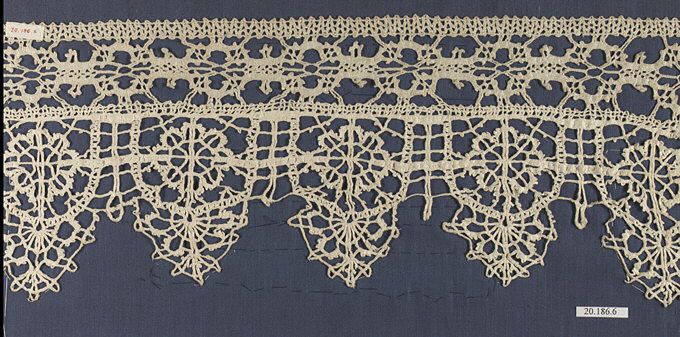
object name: edging and insertion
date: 1601-1700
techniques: lace